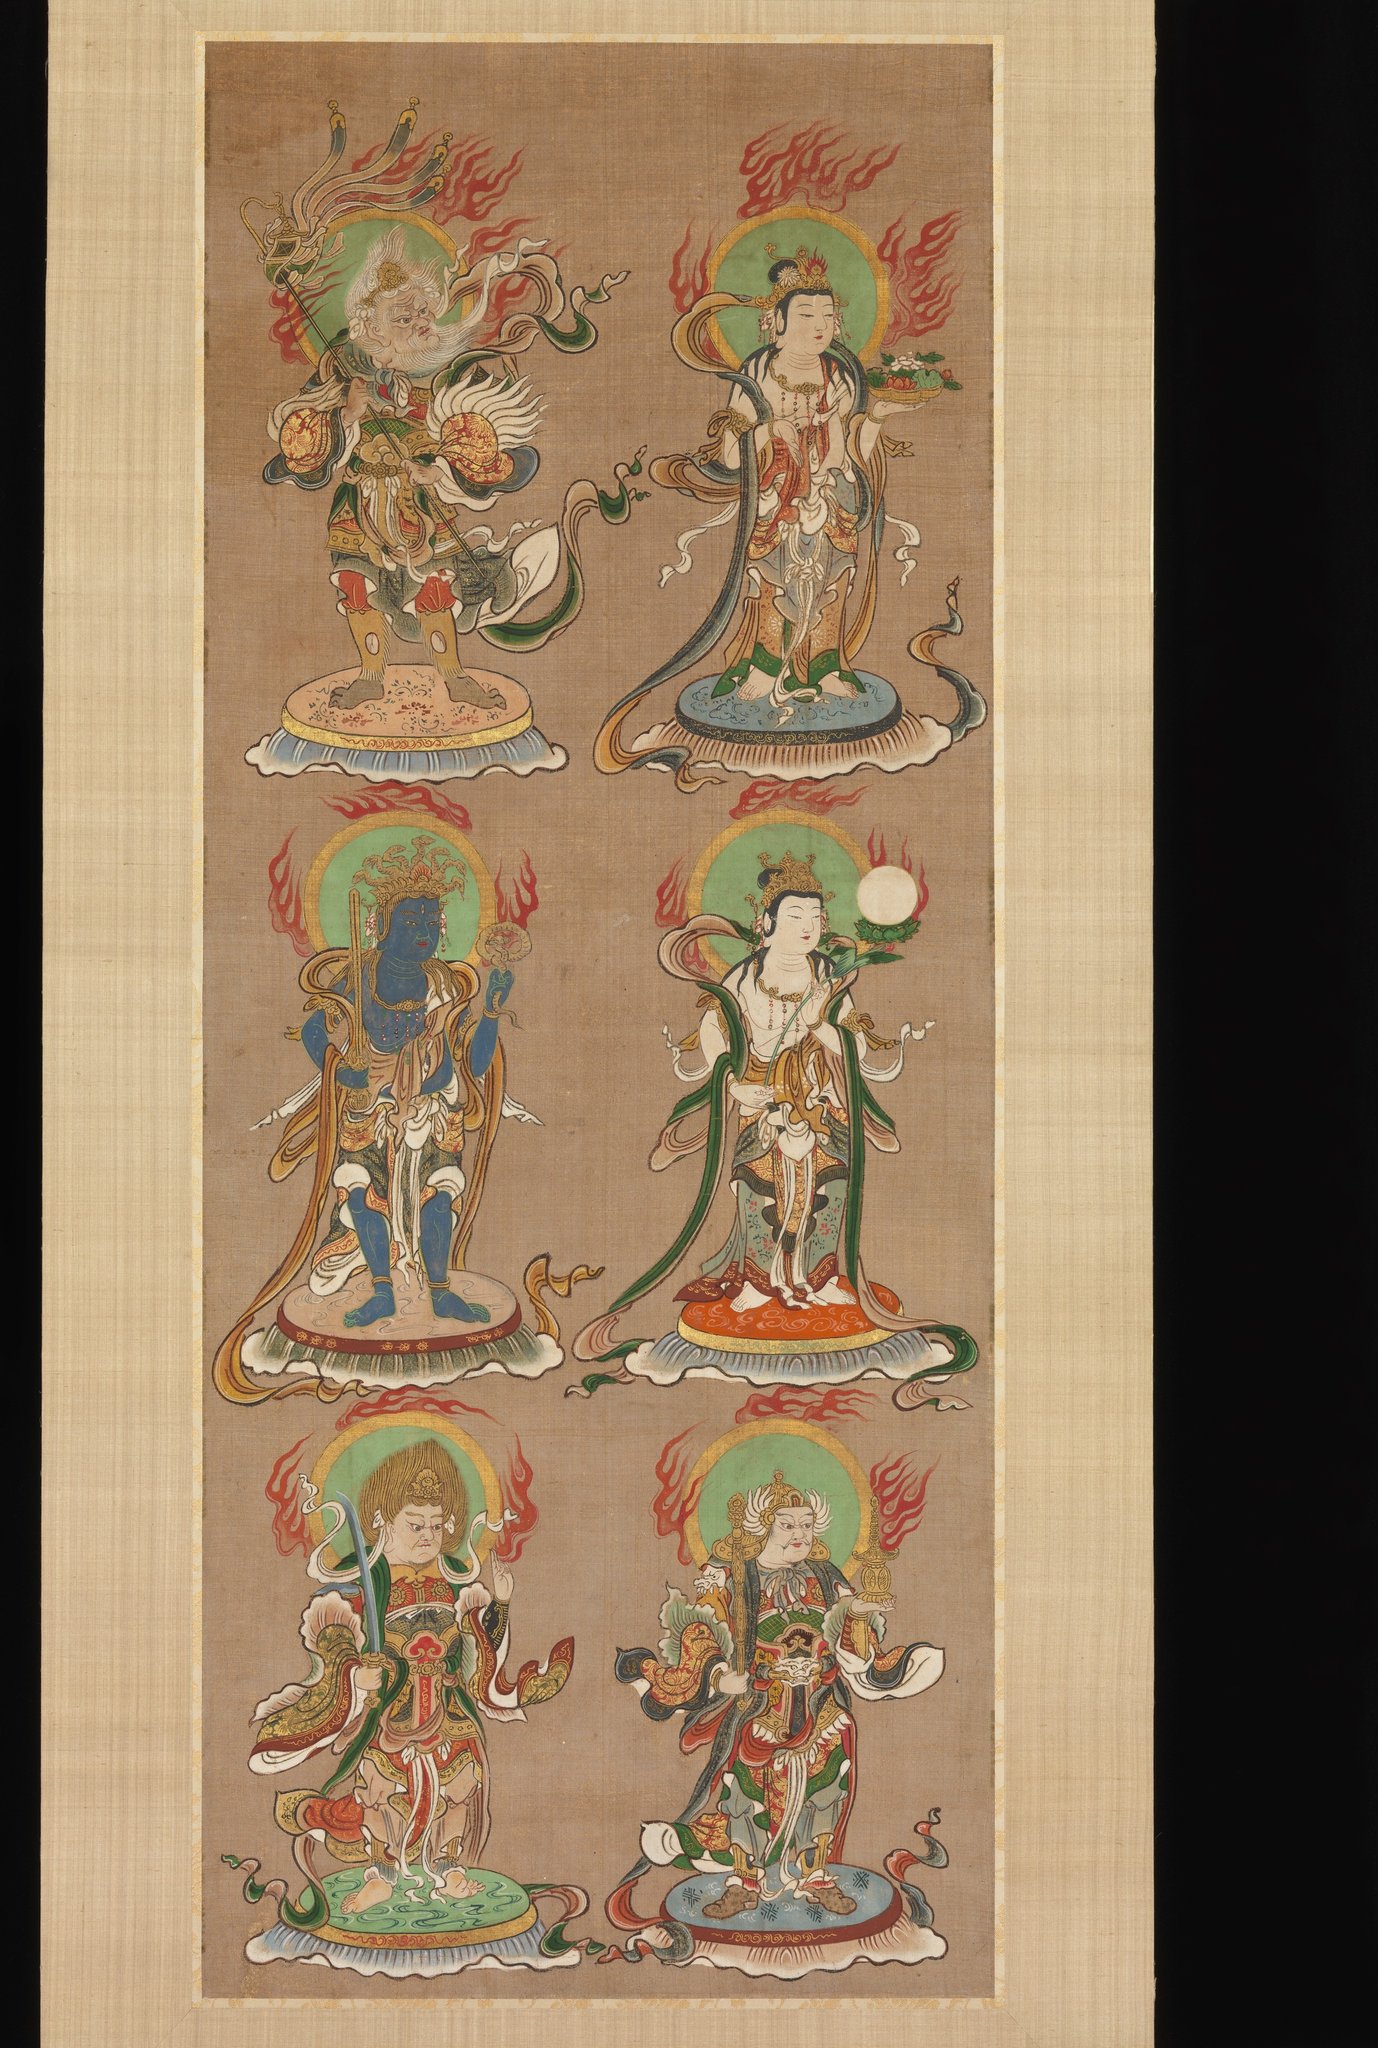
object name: painting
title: Twelve Deva Kings (Jūniten)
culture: japanese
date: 1501-1600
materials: gold, ink, silk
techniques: painting